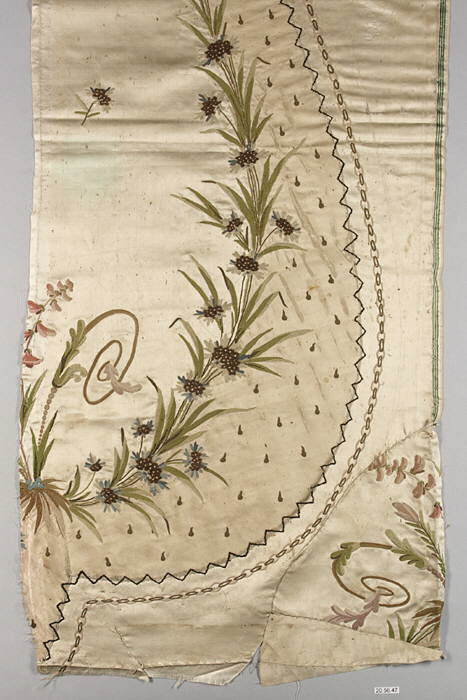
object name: piece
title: Two pieces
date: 1701-1800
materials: silk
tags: flowers,leaves